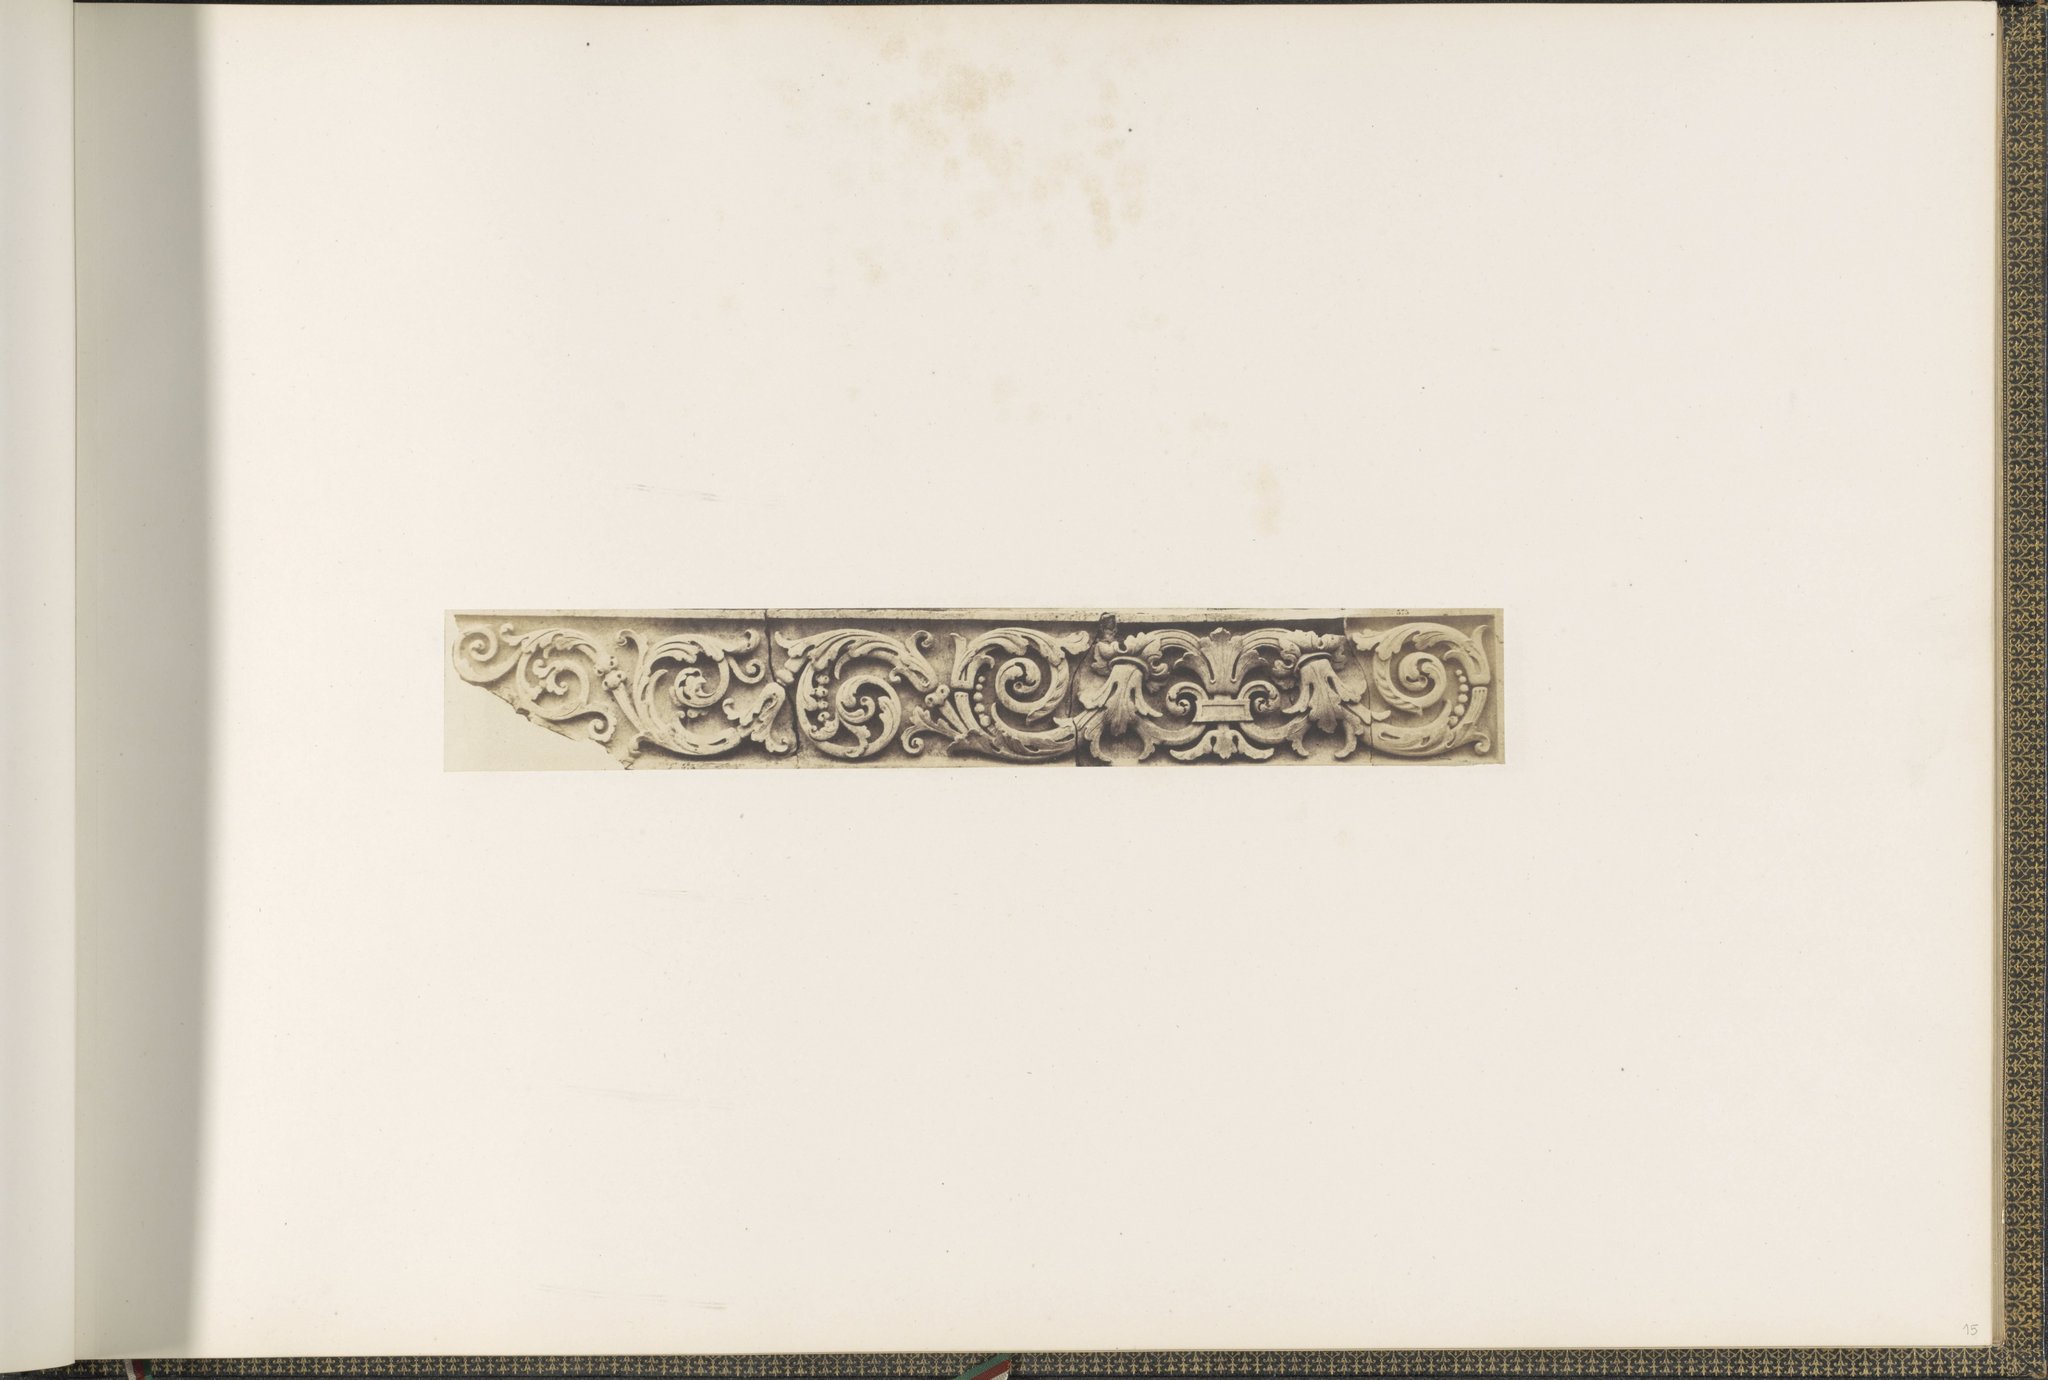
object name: album leaf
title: Gipsmodel voor versiering op de Bibliothèque Impériale van het Palais du Louvre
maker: édouard denis baldus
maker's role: fotograaf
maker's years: 1813-1889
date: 1855-1857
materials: paper, photographic support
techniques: salted paper print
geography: paris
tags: permanent exhibition, museum, ornamenting, decorating ~ applied arts, paris, tuileries palace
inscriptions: number: ‘375’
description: Onderdeel van Réunion des Tuileries au Louvre 1852-1857, album 4.